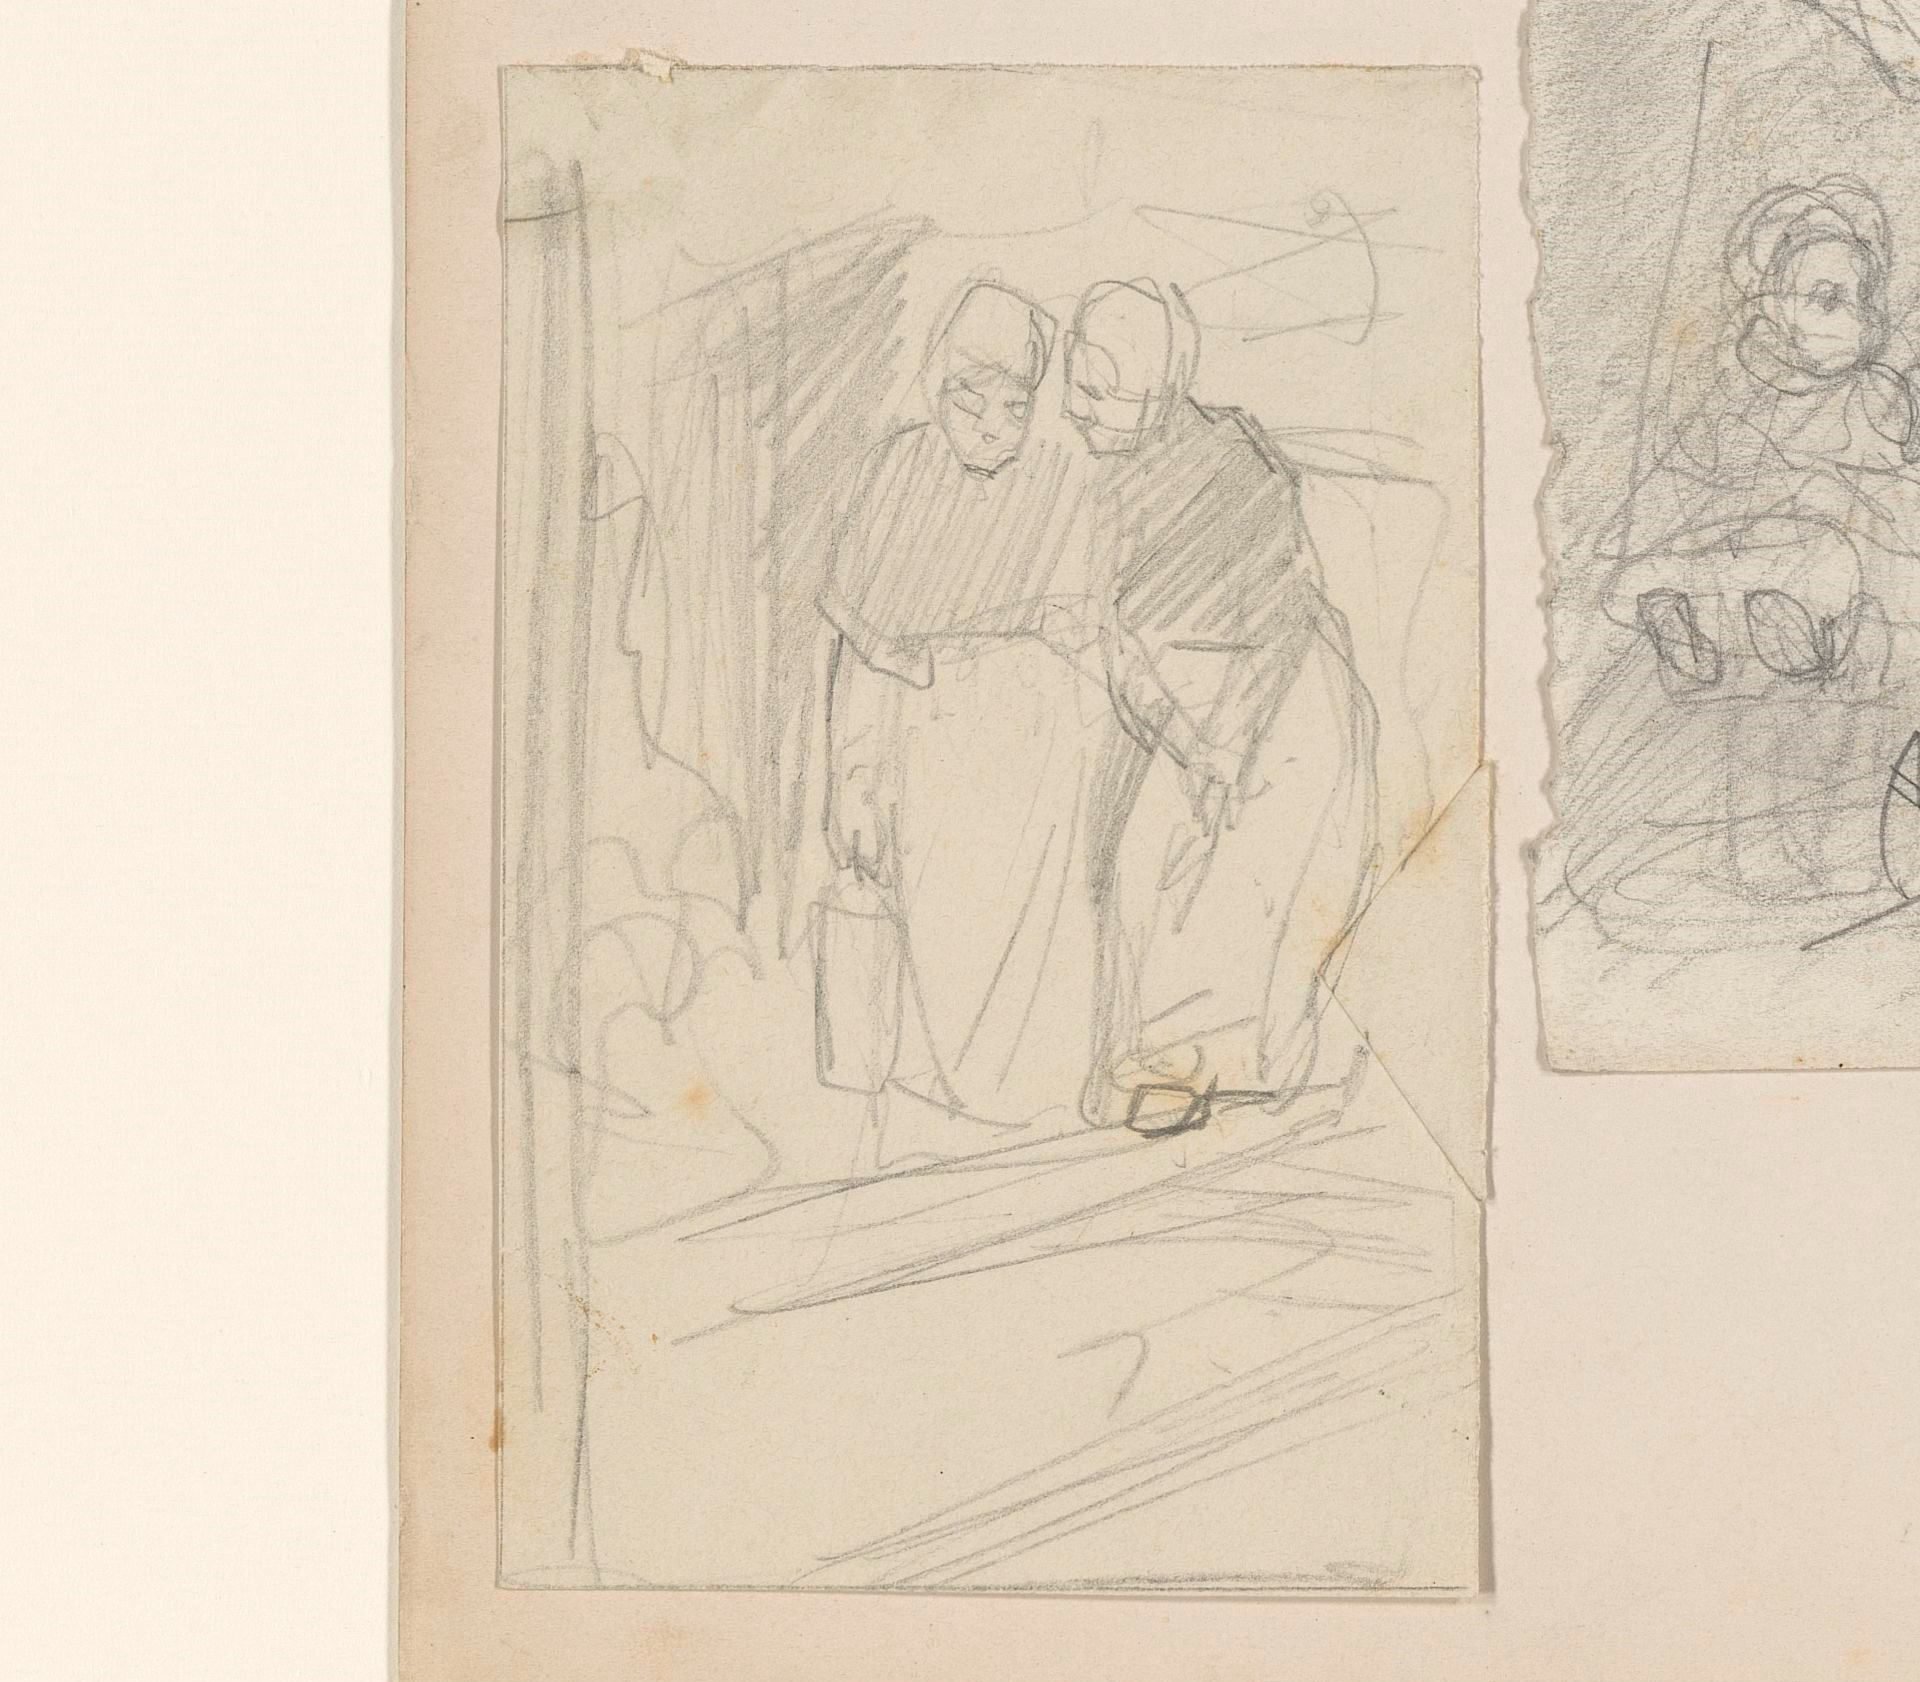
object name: drawing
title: Aardappelwinkel in de Tuinstraat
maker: august allebé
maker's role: draughtsman, print maker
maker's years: 1838-1927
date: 1848-1927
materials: paper, pencil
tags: stirring up a fire, potatoes